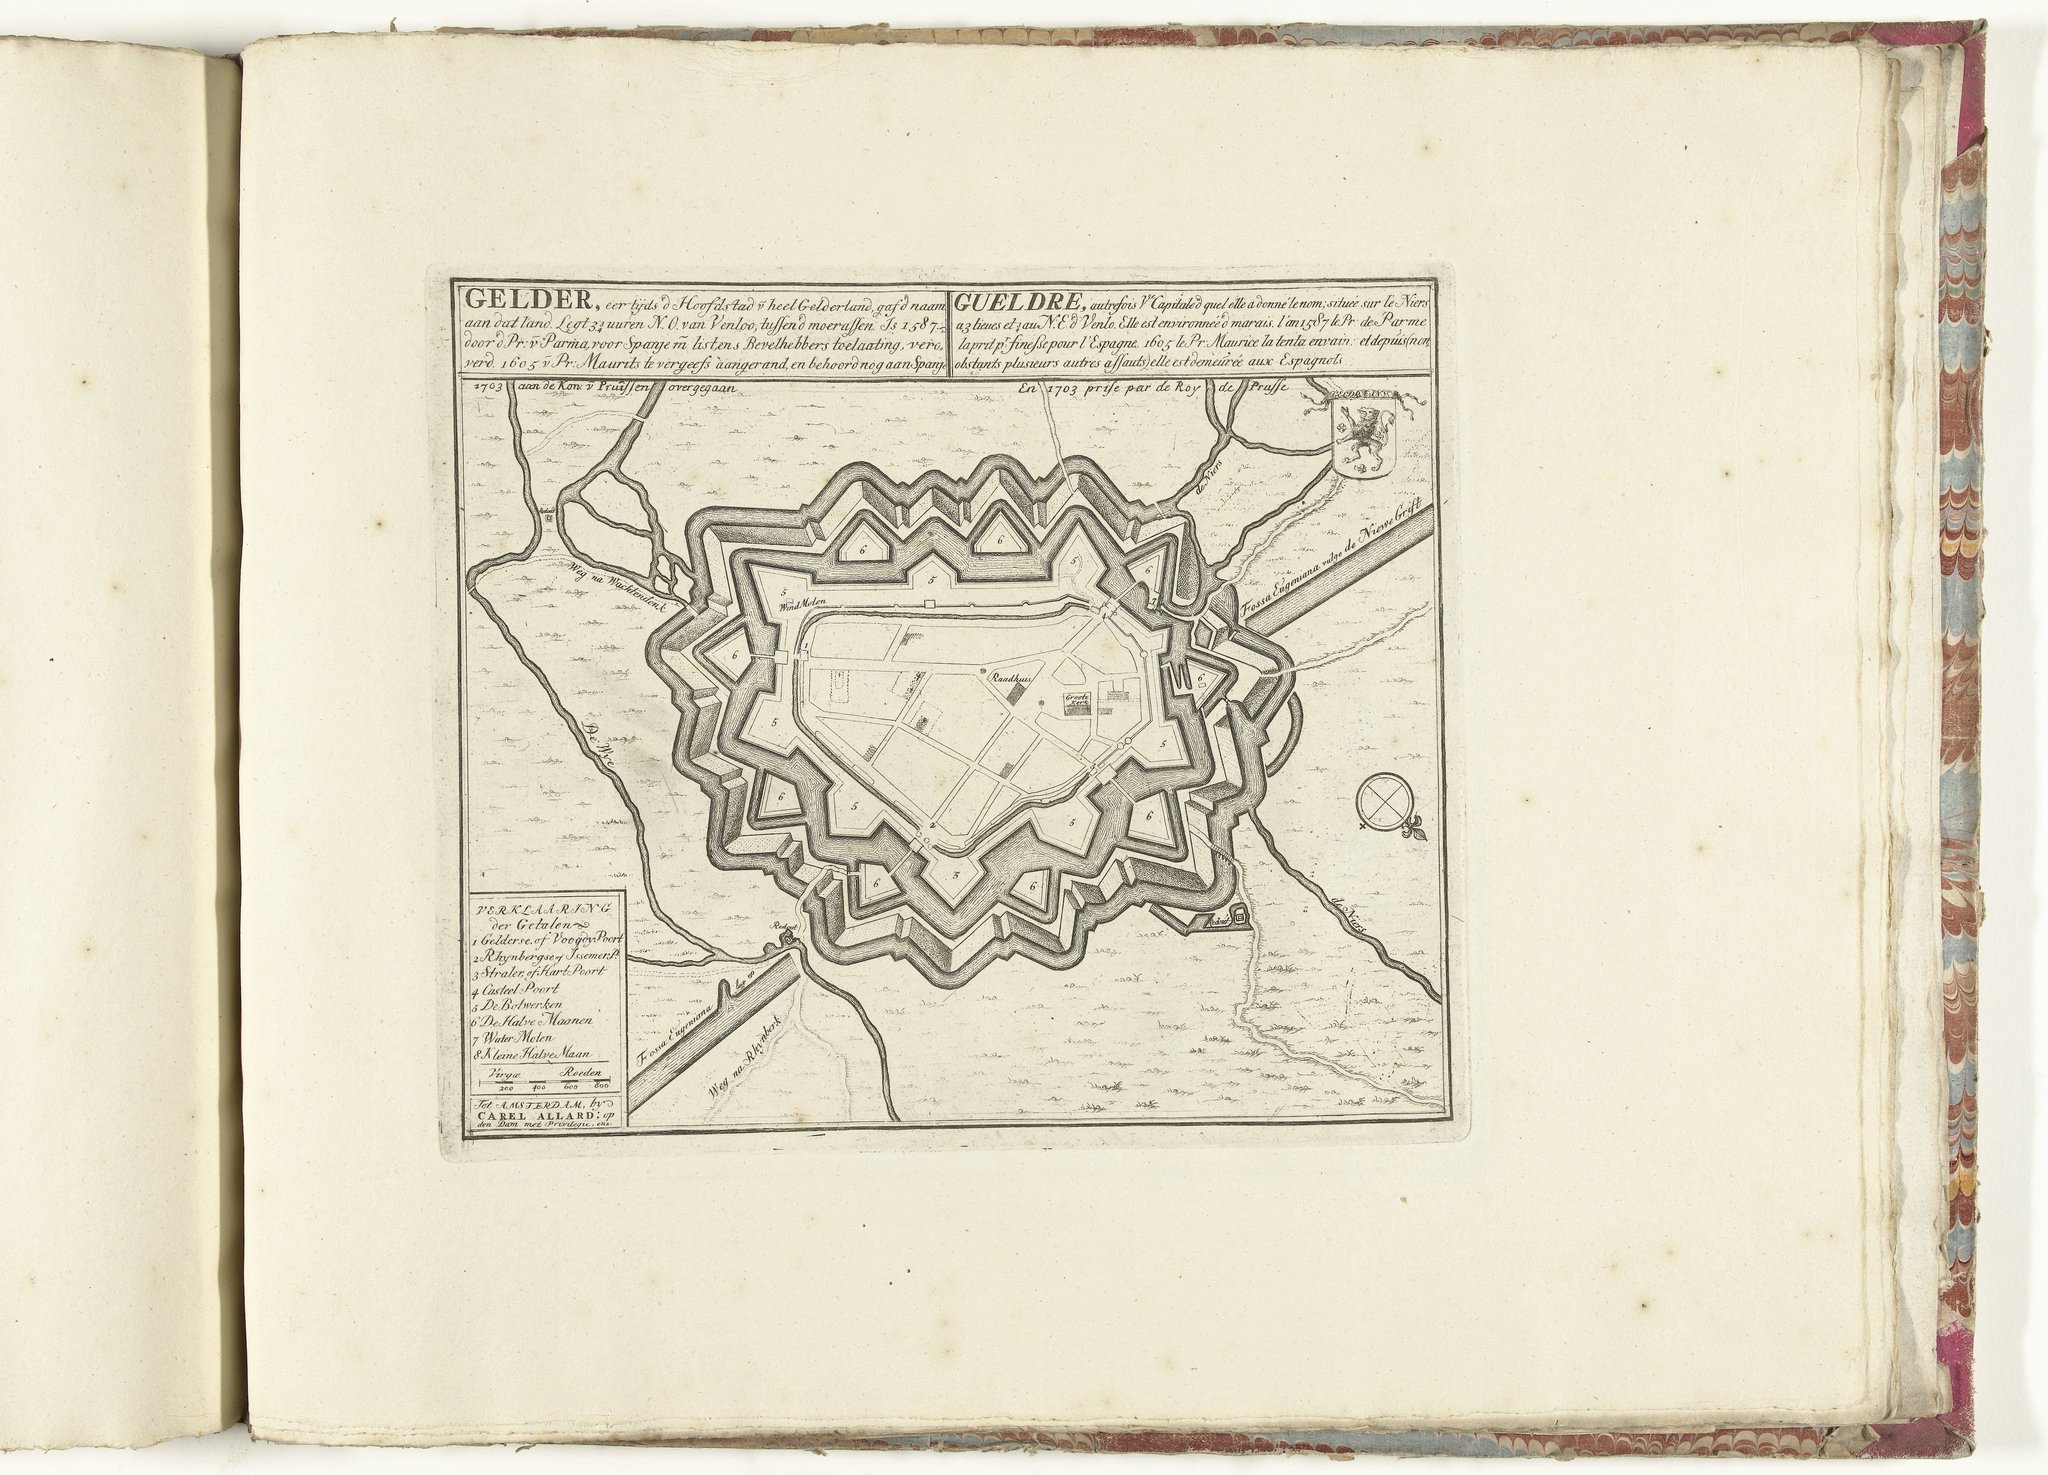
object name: map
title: Les Principales Forteresses & Villes Fortes, d'Espagne, de France, d'Italie, de Savoië, d'Allemagne & des Païs-Bas (...) / Naaukeurige Afbeeldingen der Voornaamste Sterke Steden en Vestingen in Spanjen, Vrankryk, Italien, Savoyen, Duytsland en Nederlanden (...)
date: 1703-1714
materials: paper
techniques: etching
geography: leiden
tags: maps of cities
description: Gekopieerd naar de Franse prenten in: Nicolas de Fer, Les forces de l'Europe, ou description des principales villes, avec leurs fortifications : dessignées par les meilleurs ingenieurs, particulierement celles ... de la France, dont les plans ont esté levez par M. de Vauban, Nicolas de Fer, Parijs 1693-1696, of andere voorbeelden.